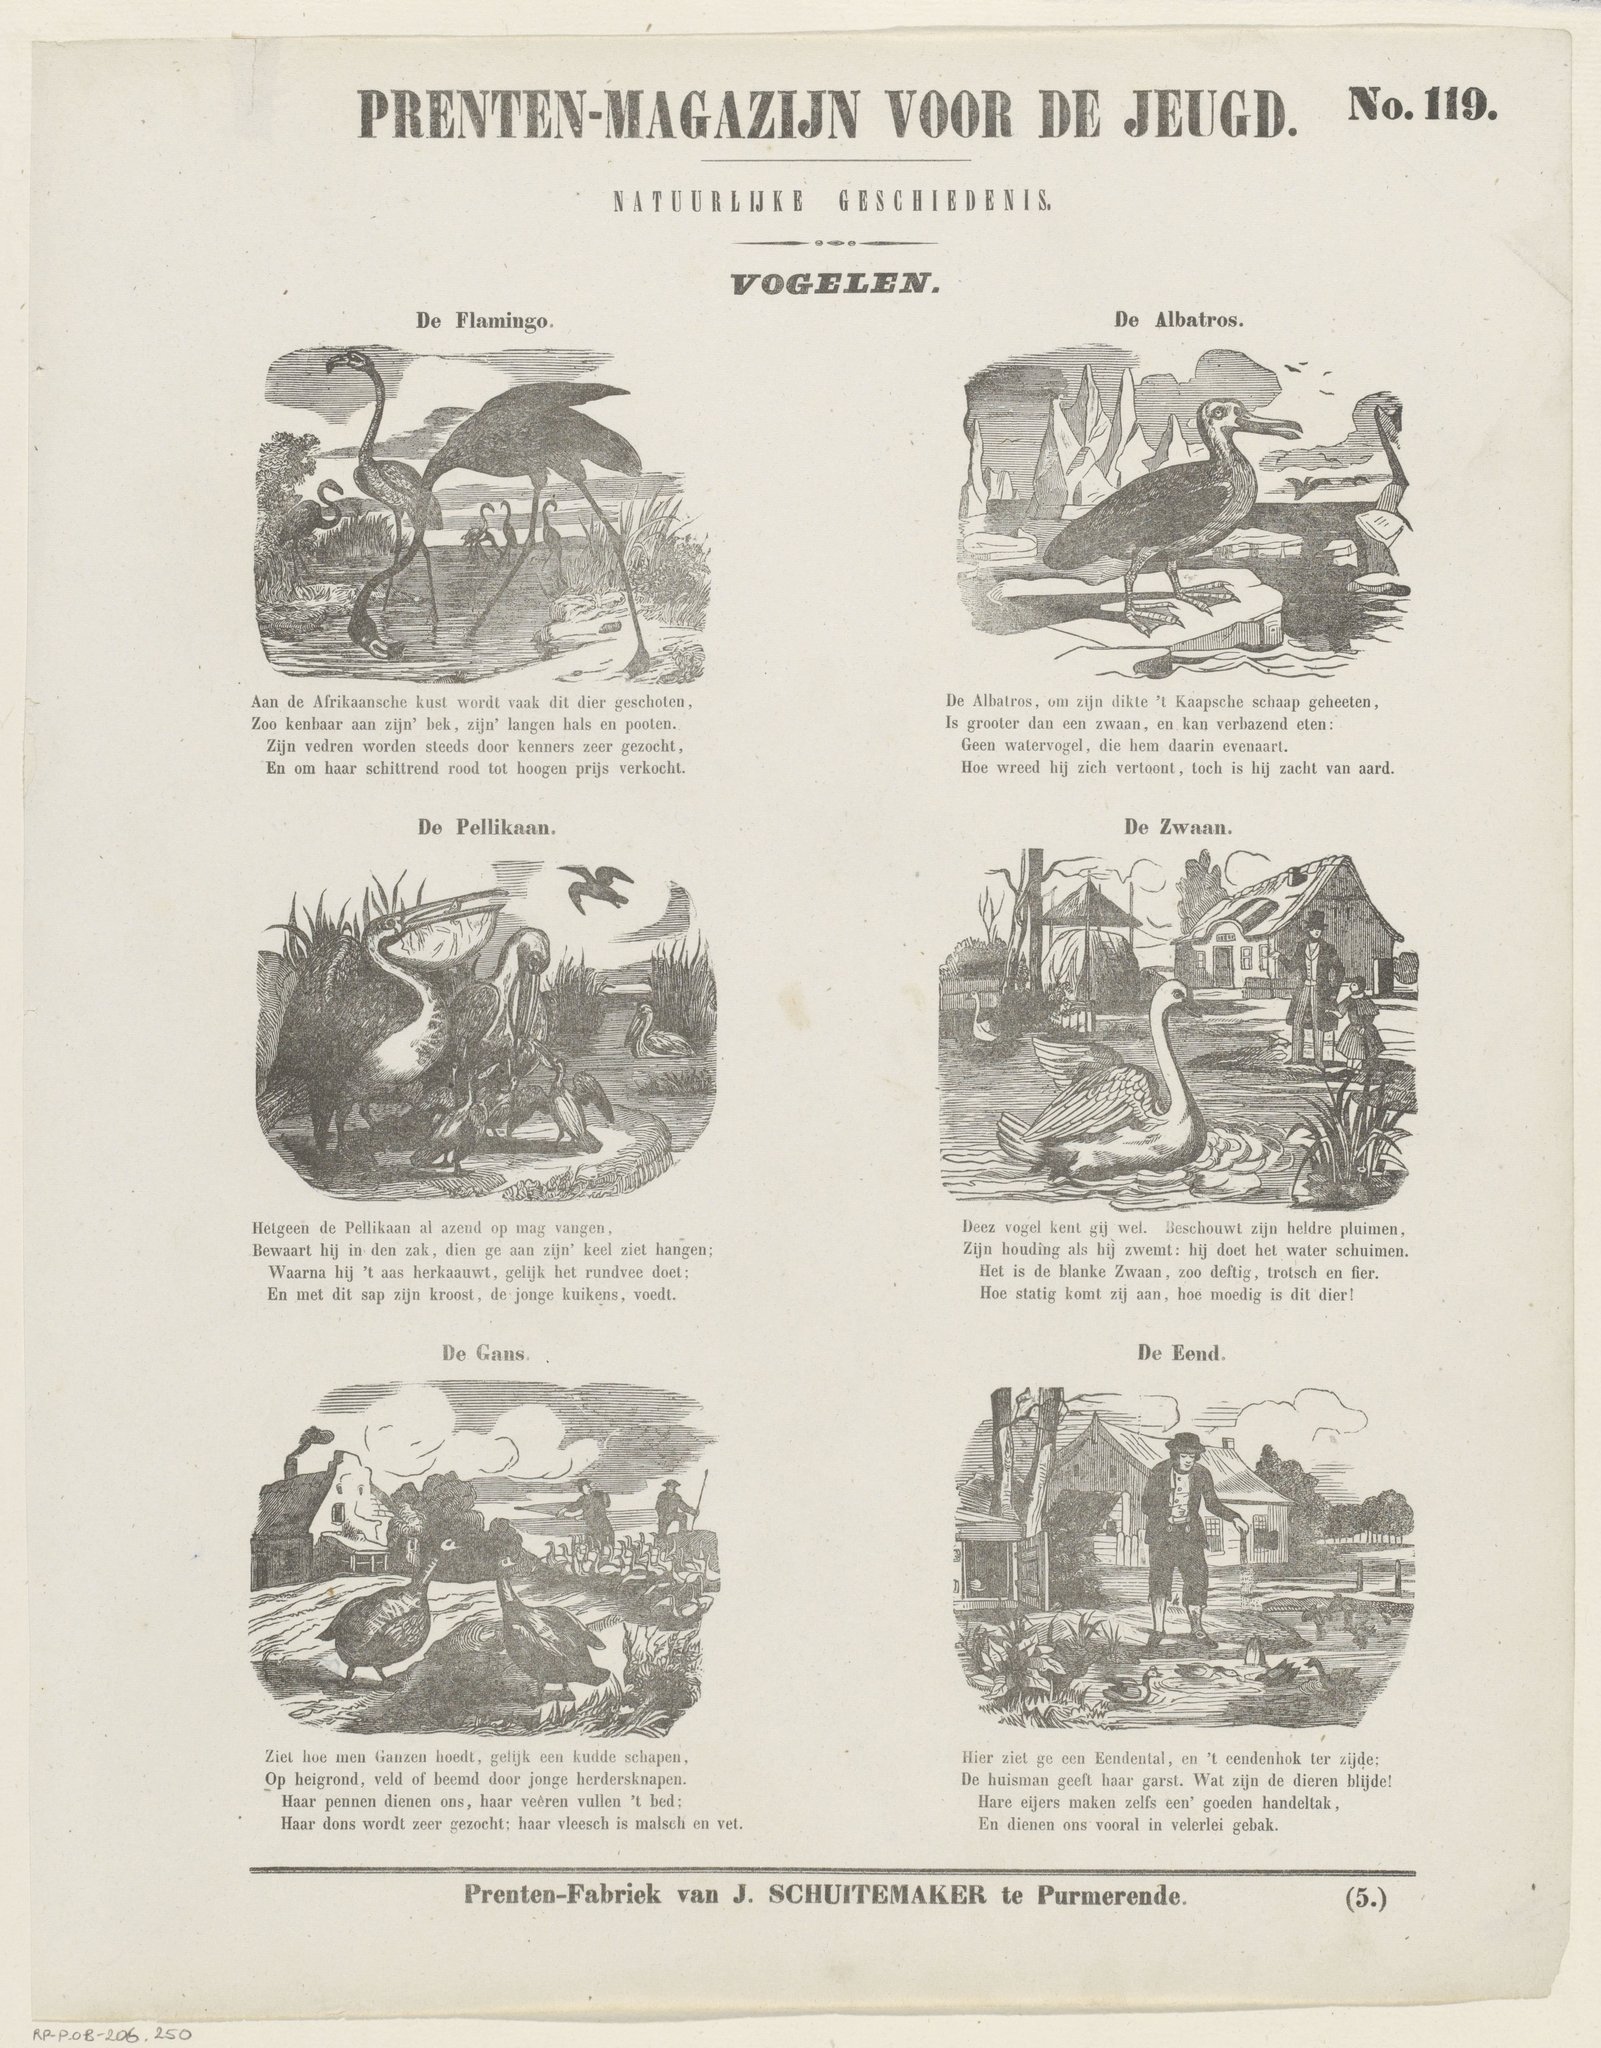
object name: popular print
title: Prenten-magazijn voor de jeugd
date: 1850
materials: paper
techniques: letterpress printing, engraving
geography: netherlands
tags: water-birds: goose, water-birds: swan, birds, water-birds: duck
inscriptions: collector's mark: Lugt 2760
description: Na voltooiing van de acht jaargangen van de reeks 'Prenten-magazijn voor de jeugd' in 1850 heeft Jan Schuitemaker al deze prenten heruitgegeven en omgenummerd als nr. 1 t/m 192. De oorspronkelijke jaargang wordt telkens nog vermeld rechtsonder op de prent. Binnen de jaargangen zijn prenten van hetzelfde thema in clusters van vier achter elkaar gezet.